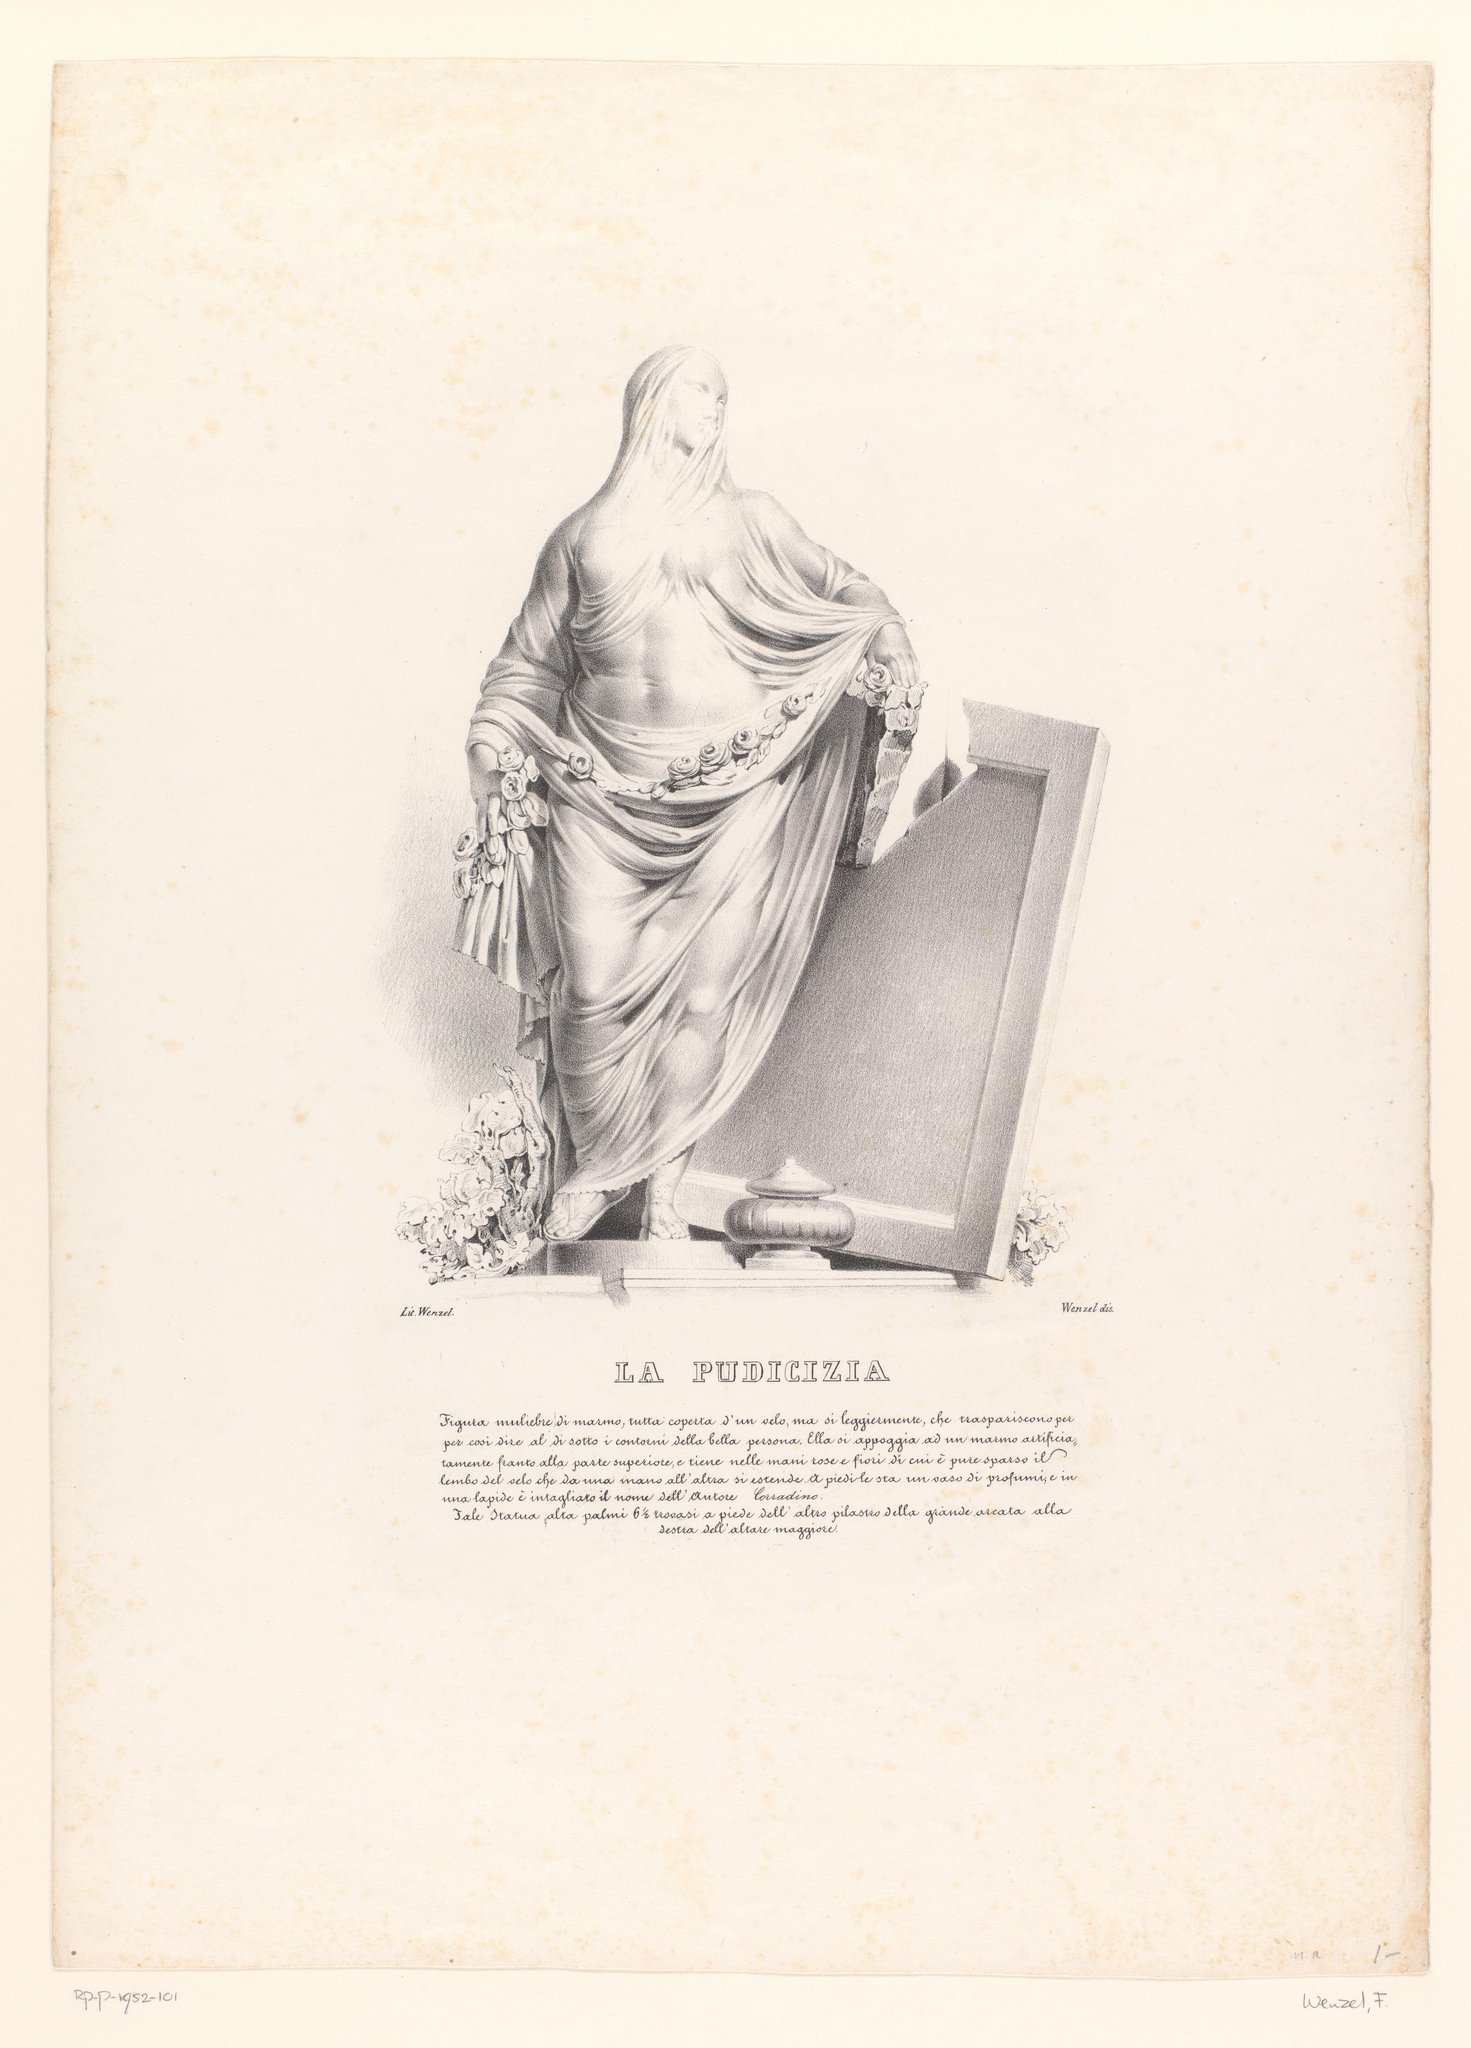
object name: print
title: Sculptuur van de Wijsheid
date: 1800-1899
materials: paper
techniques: lithograph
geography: italy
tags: wisdom; 'sapienza', 'sapienza humana', 'sapienza vera' (ripa), historical persons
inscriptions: collector's mark: Lugt 2228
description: Naar het sculptuur door Antonio Corradini in de Santa Maria della Pietrà dei Sangro te Napels. Deze prent maakt deel uit van een reeks prenten van onbekende omvang met voorstellingen van sculpturen in de Santa Maria della Pietrà dei Sangro te Napels.